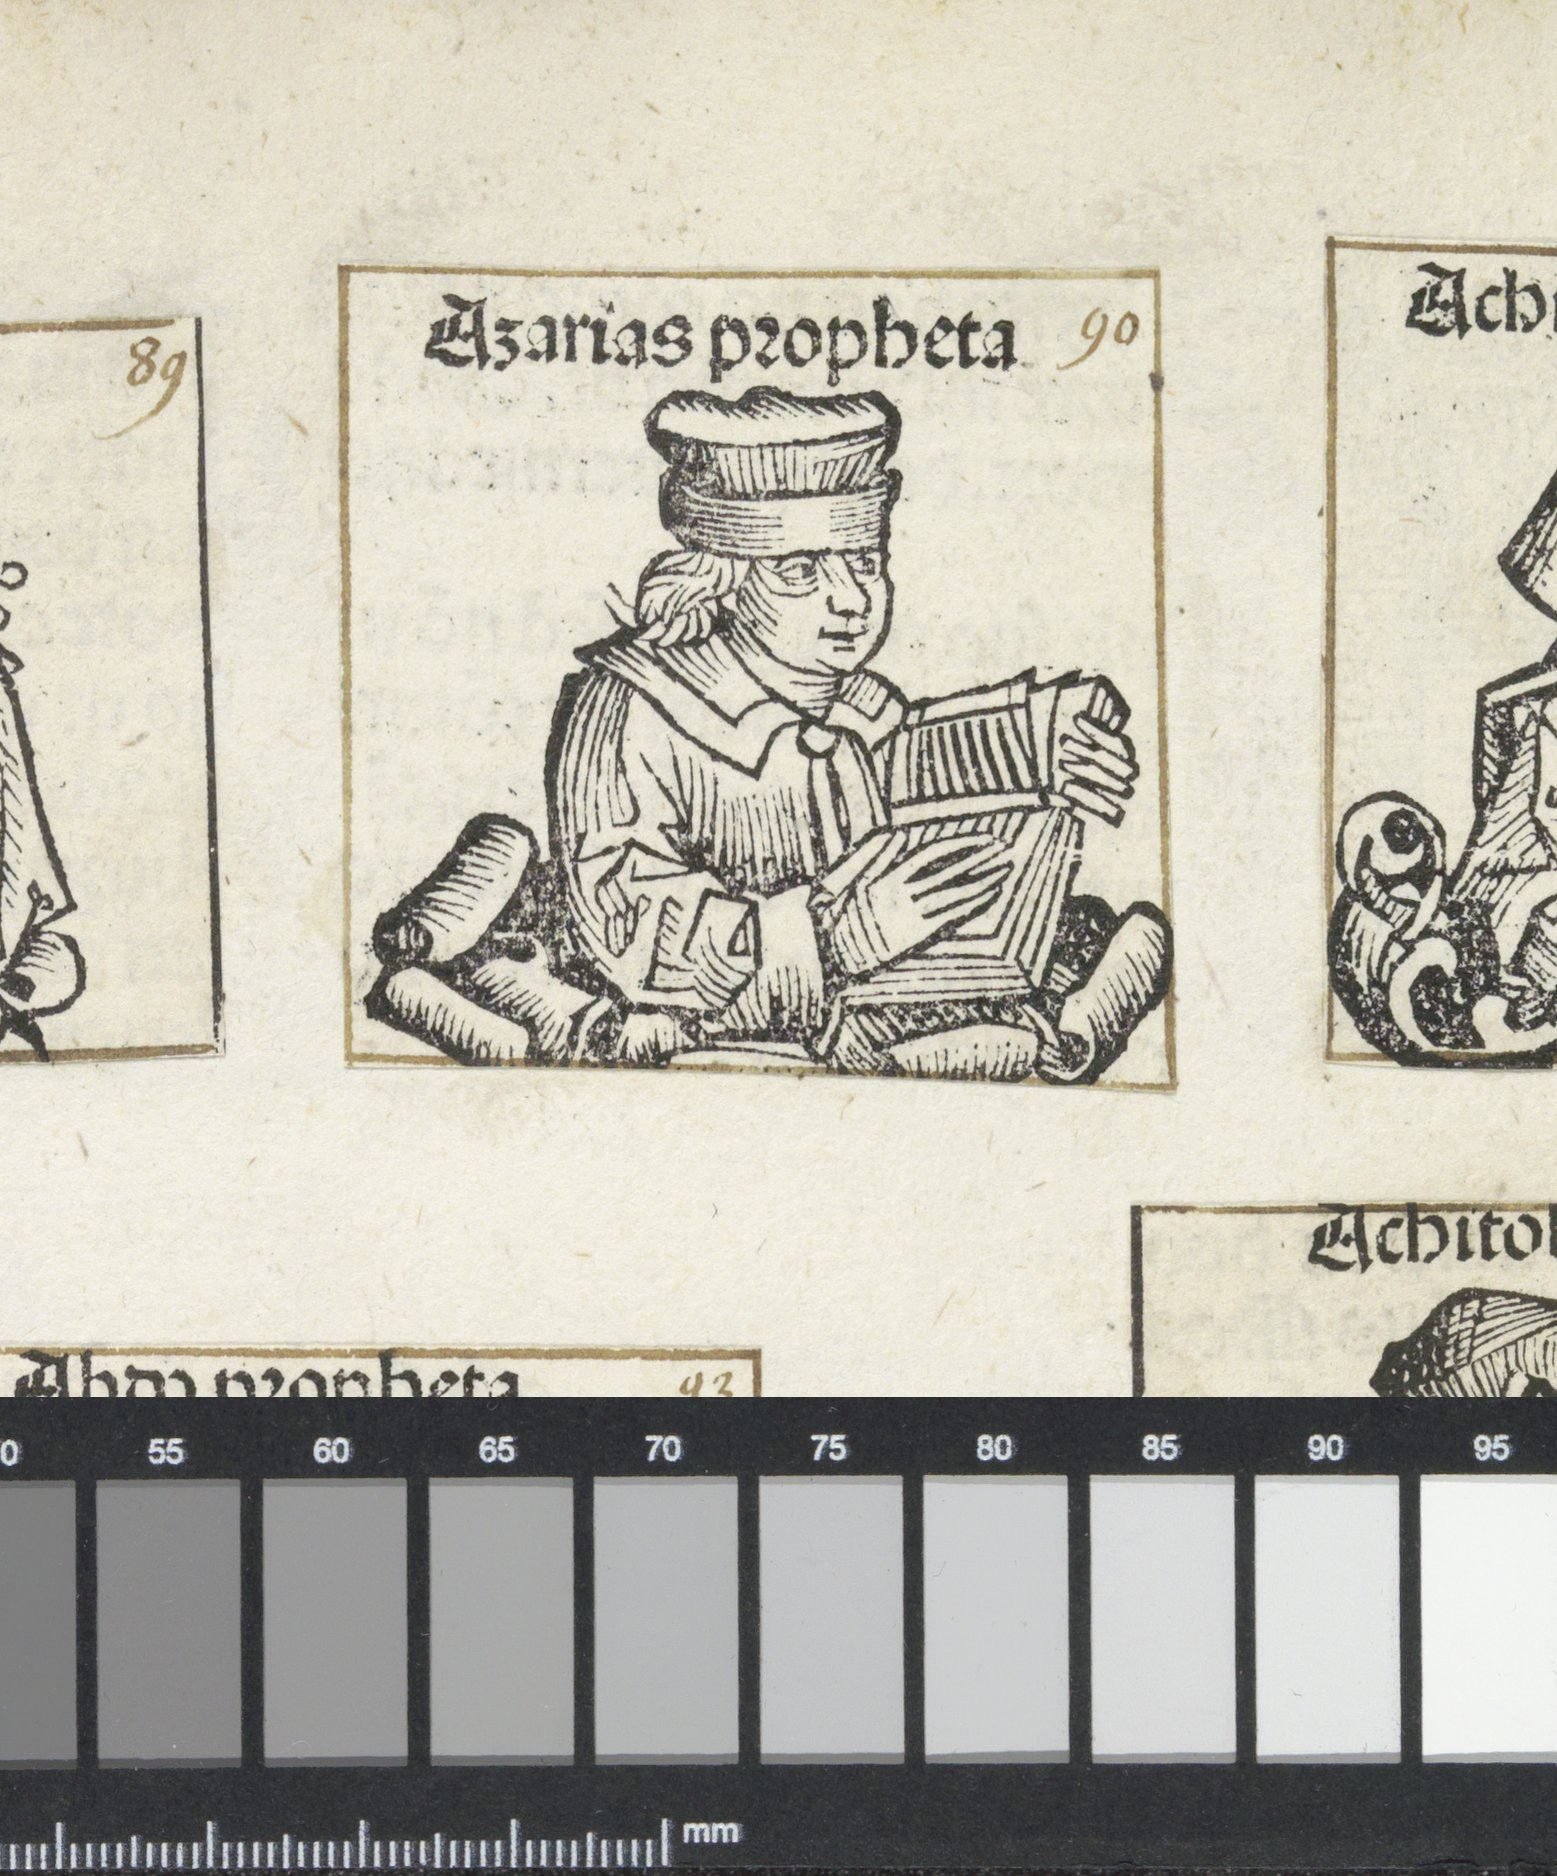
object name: print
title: Liber Chronicarum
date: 1493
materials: paper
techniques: letterpress printing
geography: nuremberg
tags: reading, persons from the old testament (not in biblical context, nor occurring in legendary/historical extensions included in division 71)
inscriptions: inscription: ‘90’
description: De houtsnede wordt gebruikt als boekillustratie in de Liber Chronicarum (of Neurenbergkroniek) van Hartmann Schedel, verschenen in het Latijn en Duits in 1493. Zie de Latijnse uitgave, folio 49v.